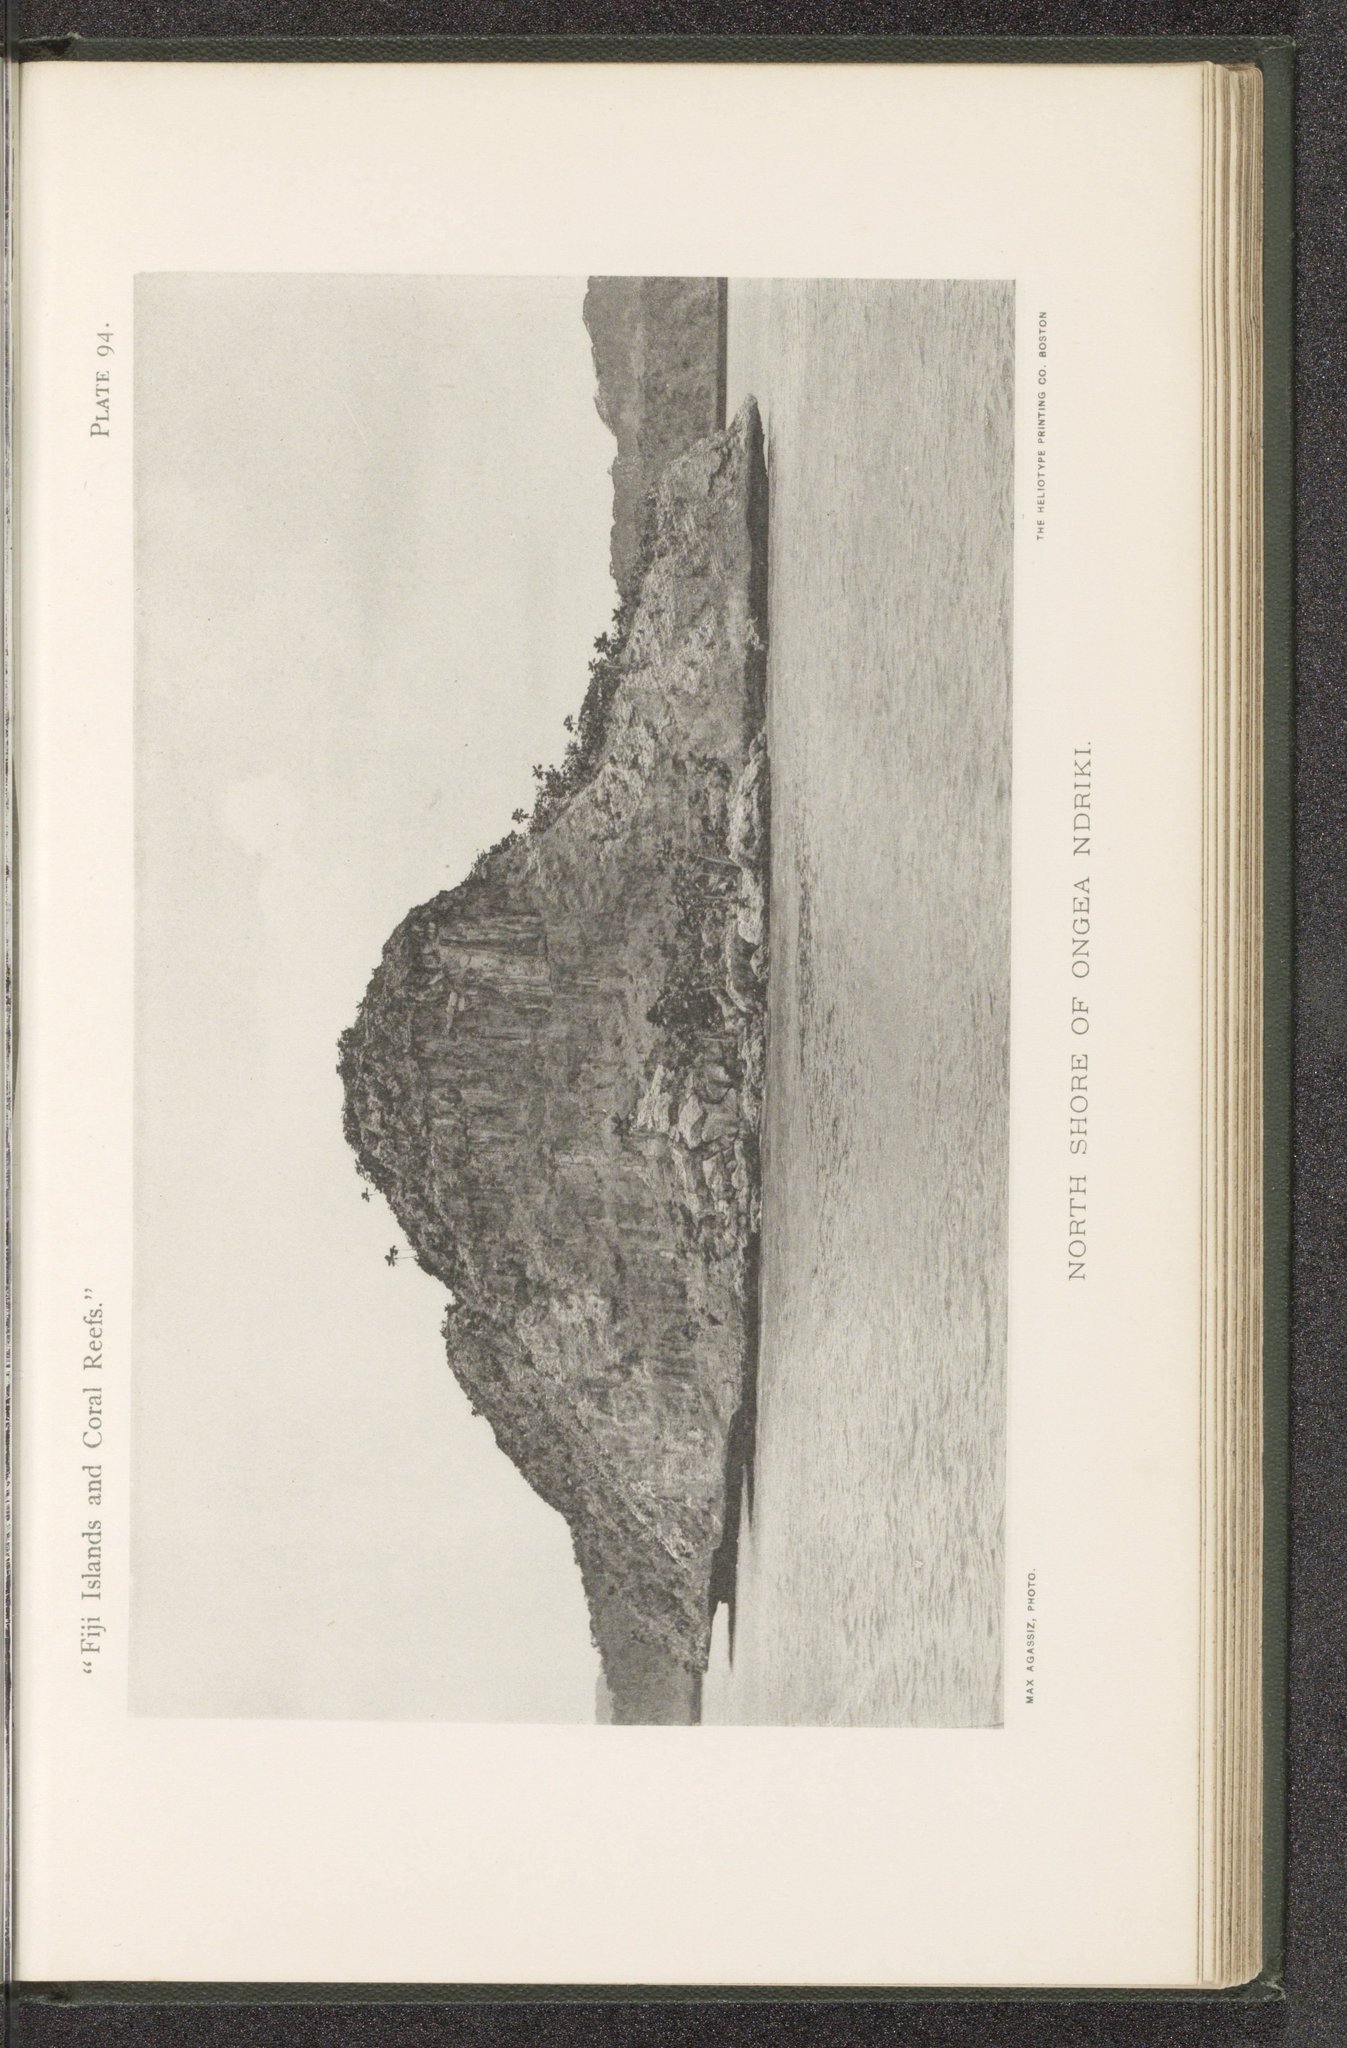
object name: photomechanical print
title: Gezicht op Ogea Driki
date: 1885-1899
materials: paper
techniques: photograph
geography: boston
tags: gulf, bay, island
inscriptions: number: ‘Plate 94.’, name: ‘The Heliotype Printing Co. Boston’, name: ‘Max Agassiz, Photo.’